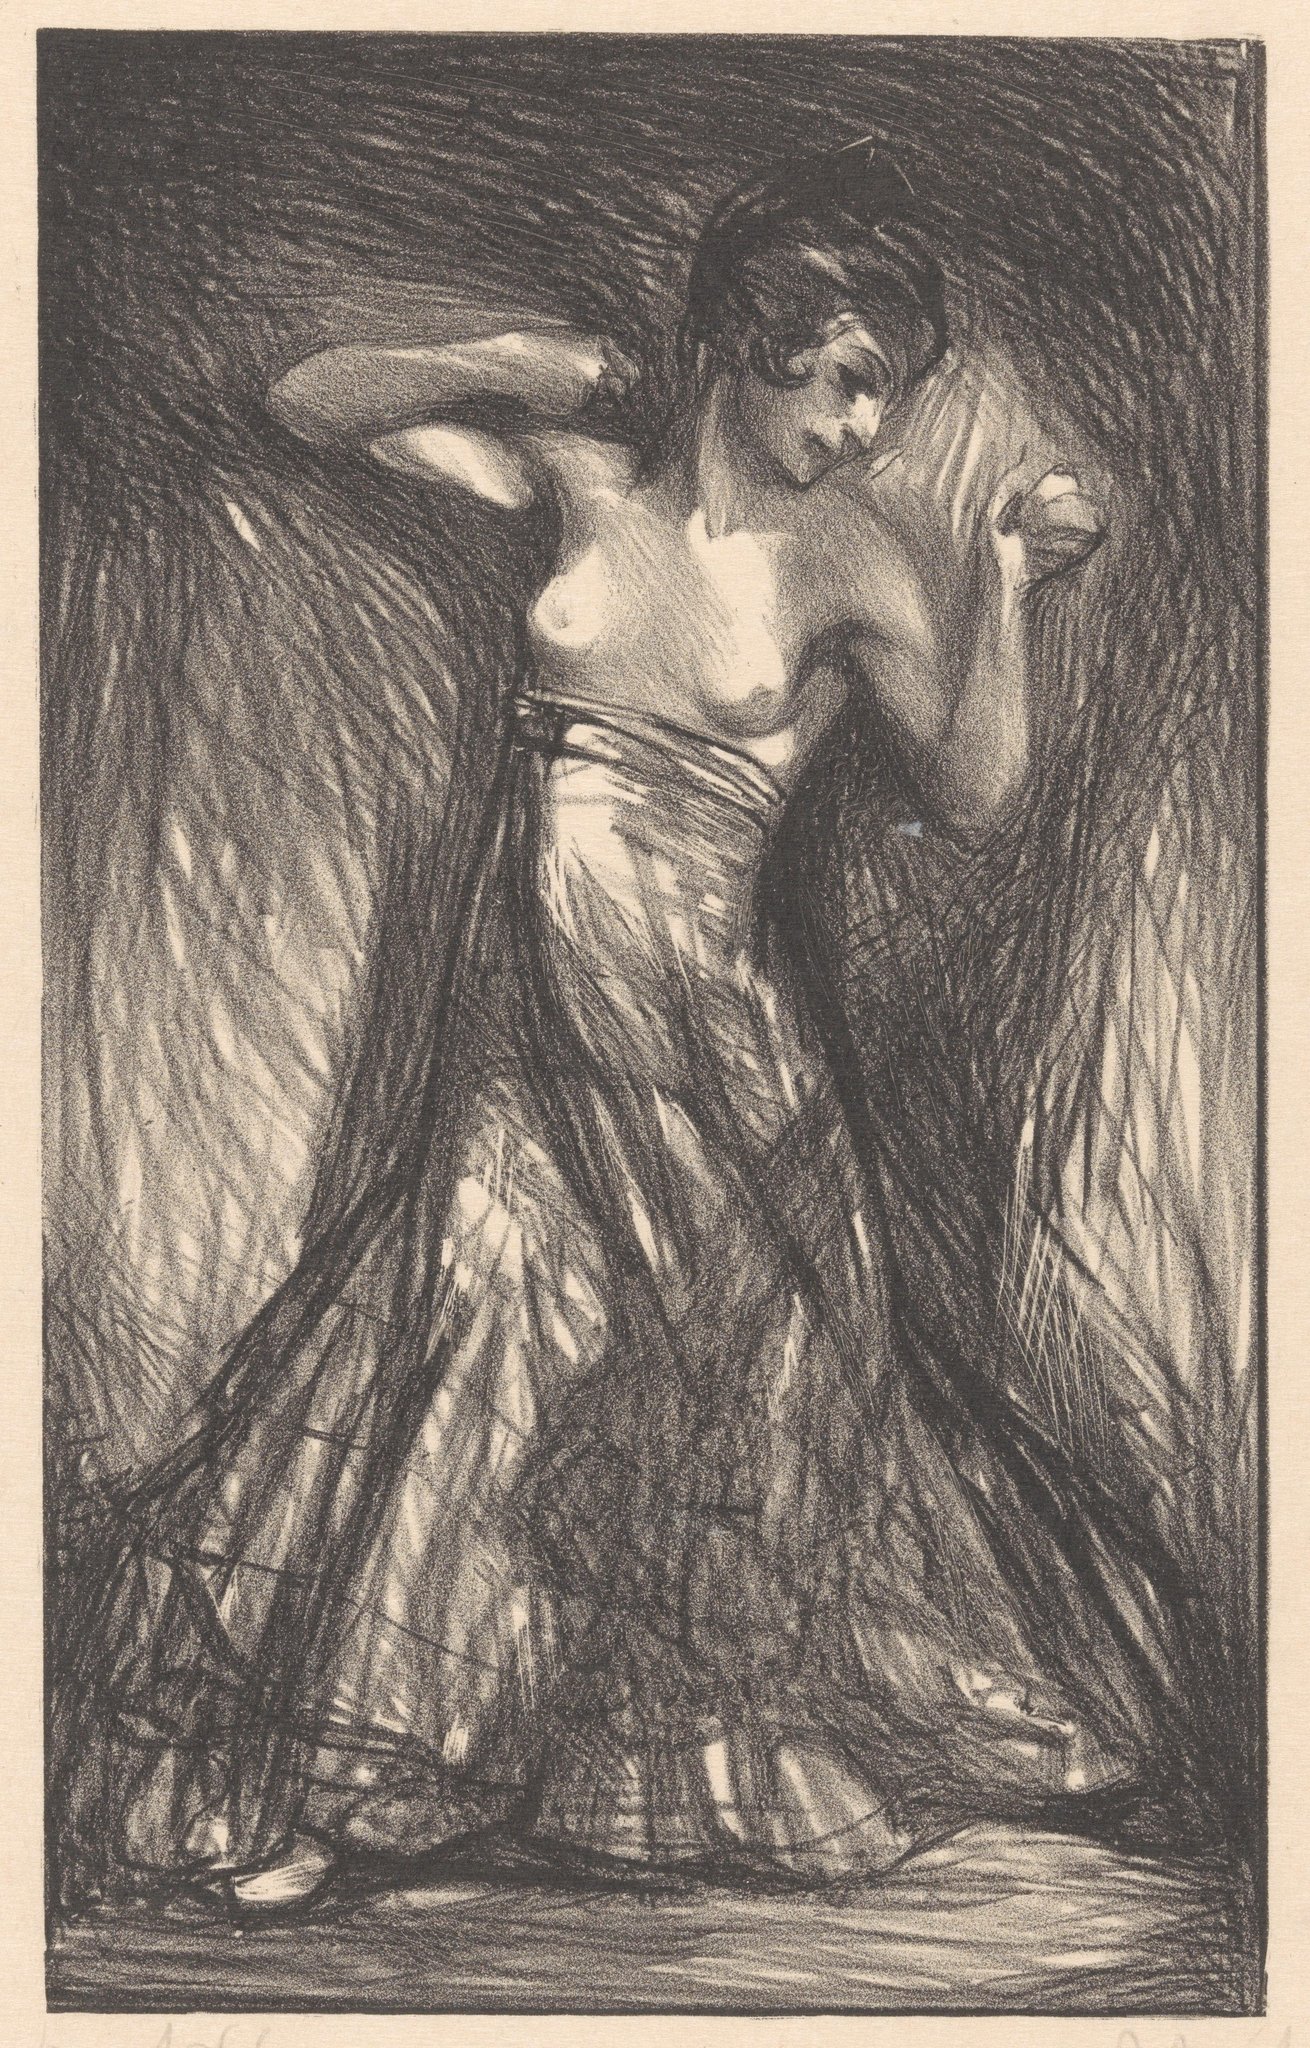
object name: print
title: Dansende vrouw met ontbloot bovenlijf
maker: johannes josephus aarts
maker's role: draughtsman, print maker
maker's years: 1871-1934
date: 1927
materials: paper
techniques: lithograph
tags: woman dancing alone, breasts - aa - female human figure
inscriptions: collector's mark: Lugt 2228, collector's mark: Lugt 2760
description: Een dansende vrouw gehuld in een rok. Haar bovenlijf is naakt.